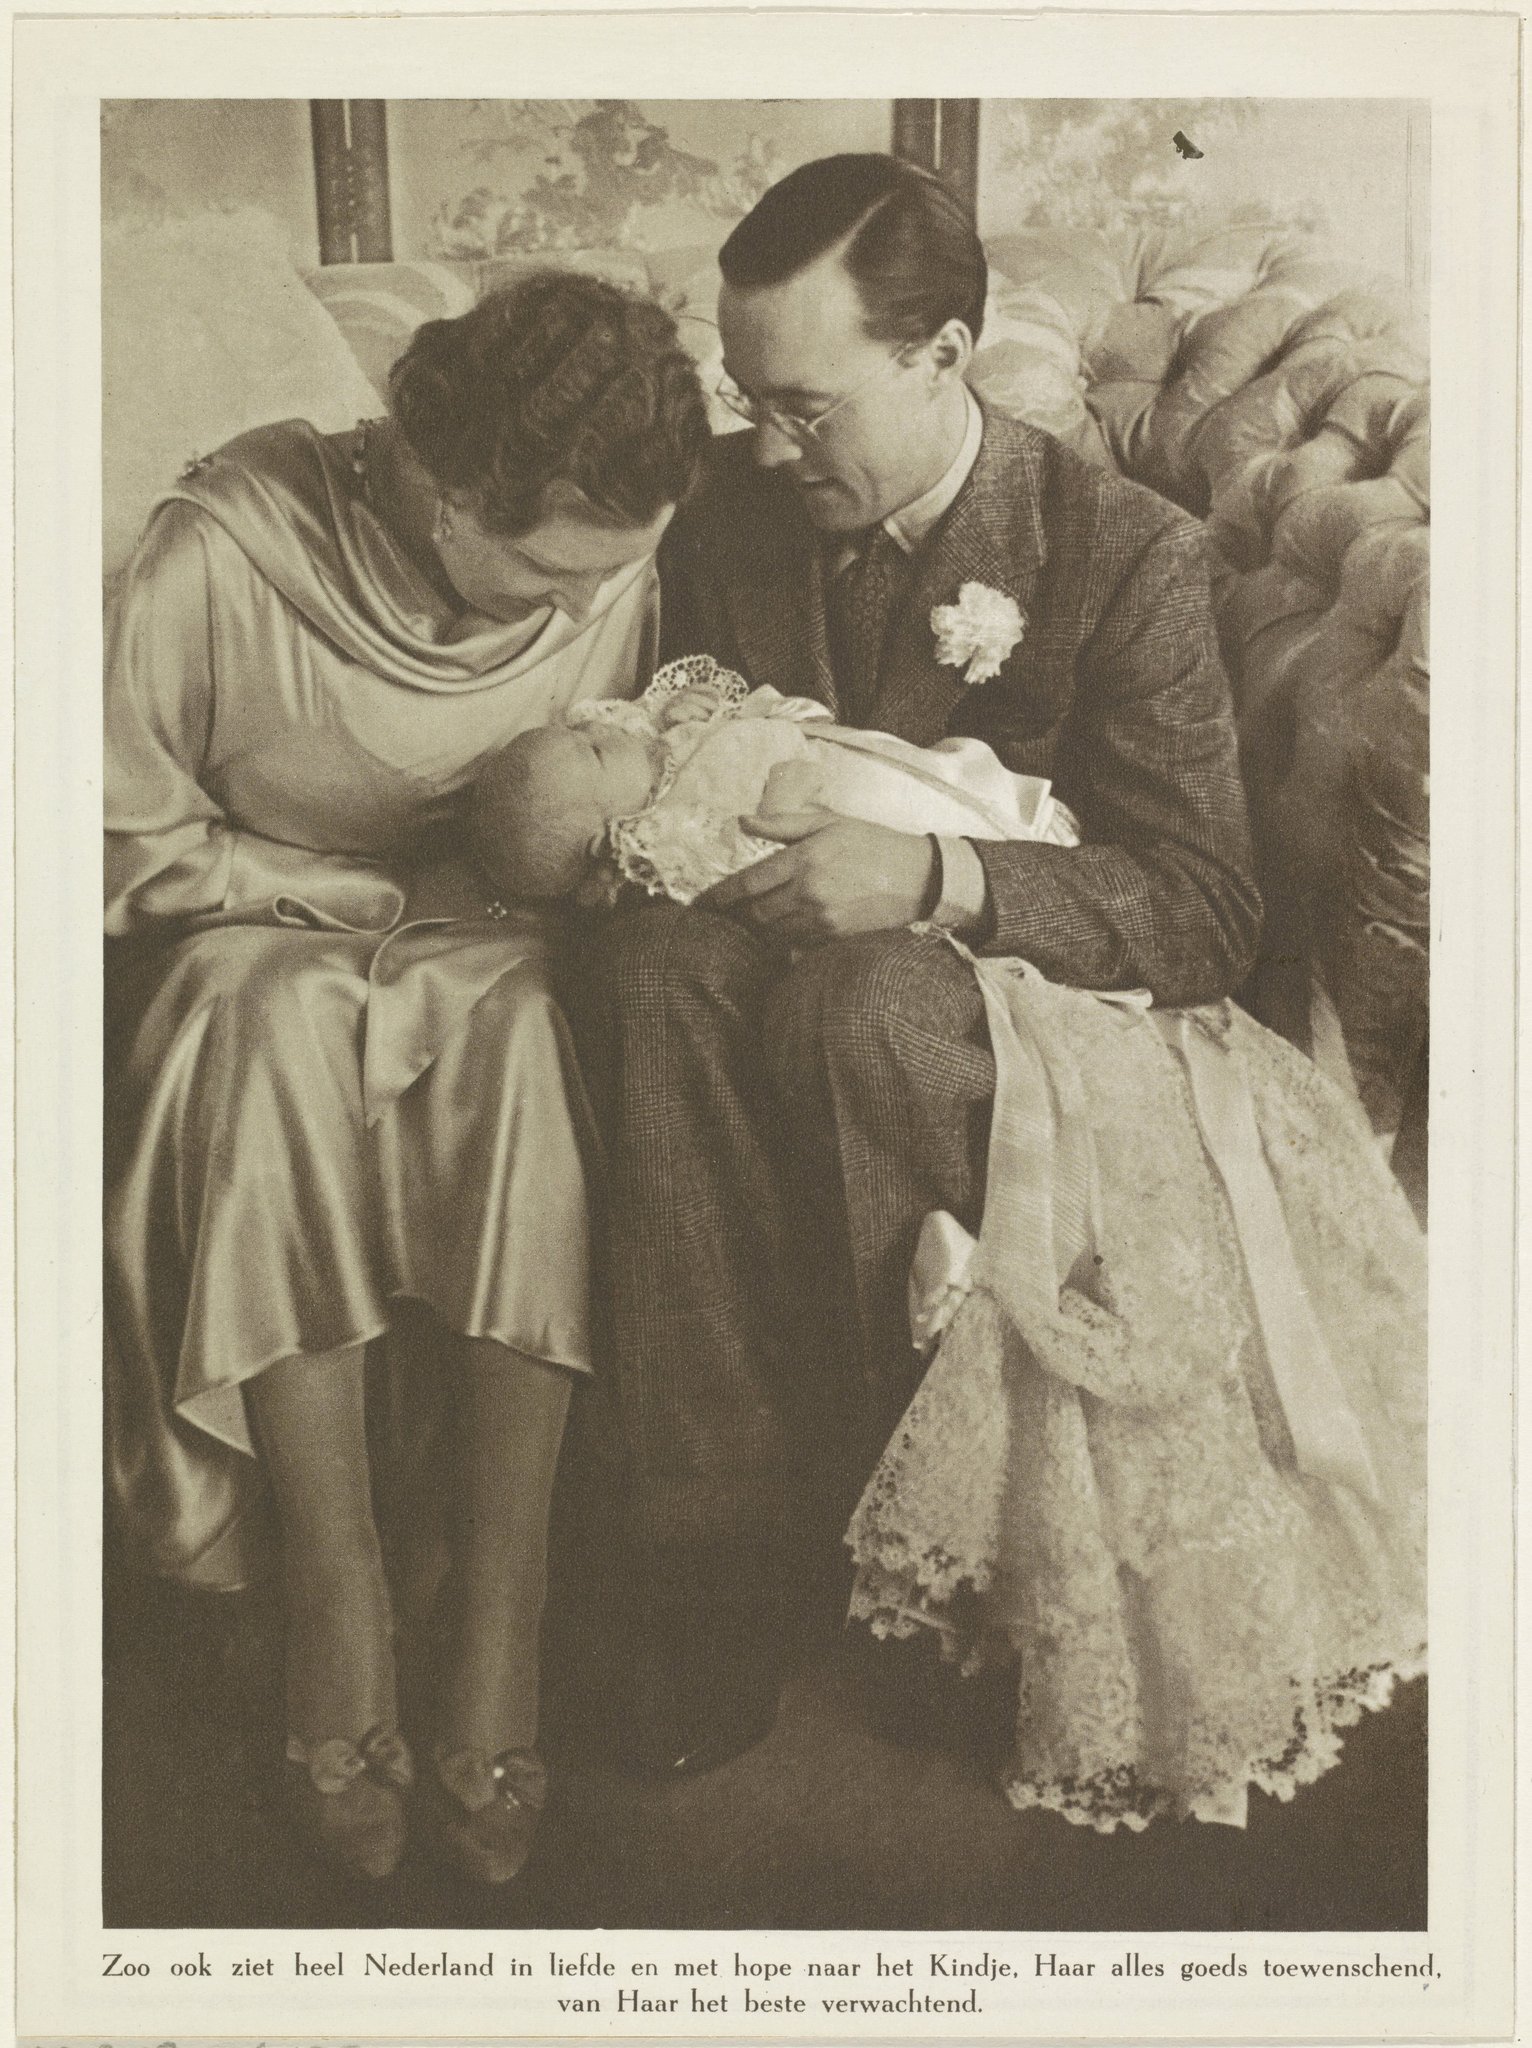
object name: photomechanical print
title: Portret van Juliana, koningin der Nederlanden, Bernhard van Lippe-Biesterfeld en Beatrix, koningin der Nederlanden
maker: Anonymous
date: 1938-1940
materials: paper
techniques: rotogravure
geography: netherlands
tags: utrecht, bernhard (prins der nederlanden), beatrix (koningin der nederlanden), the hague, juliana of the netherlands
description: De hier vermelde titel verwijst naar de hoogst verkregen titel van de geportretteerde, niet per se naar de titel die de geportretteerde op deze voorstelling draagt.